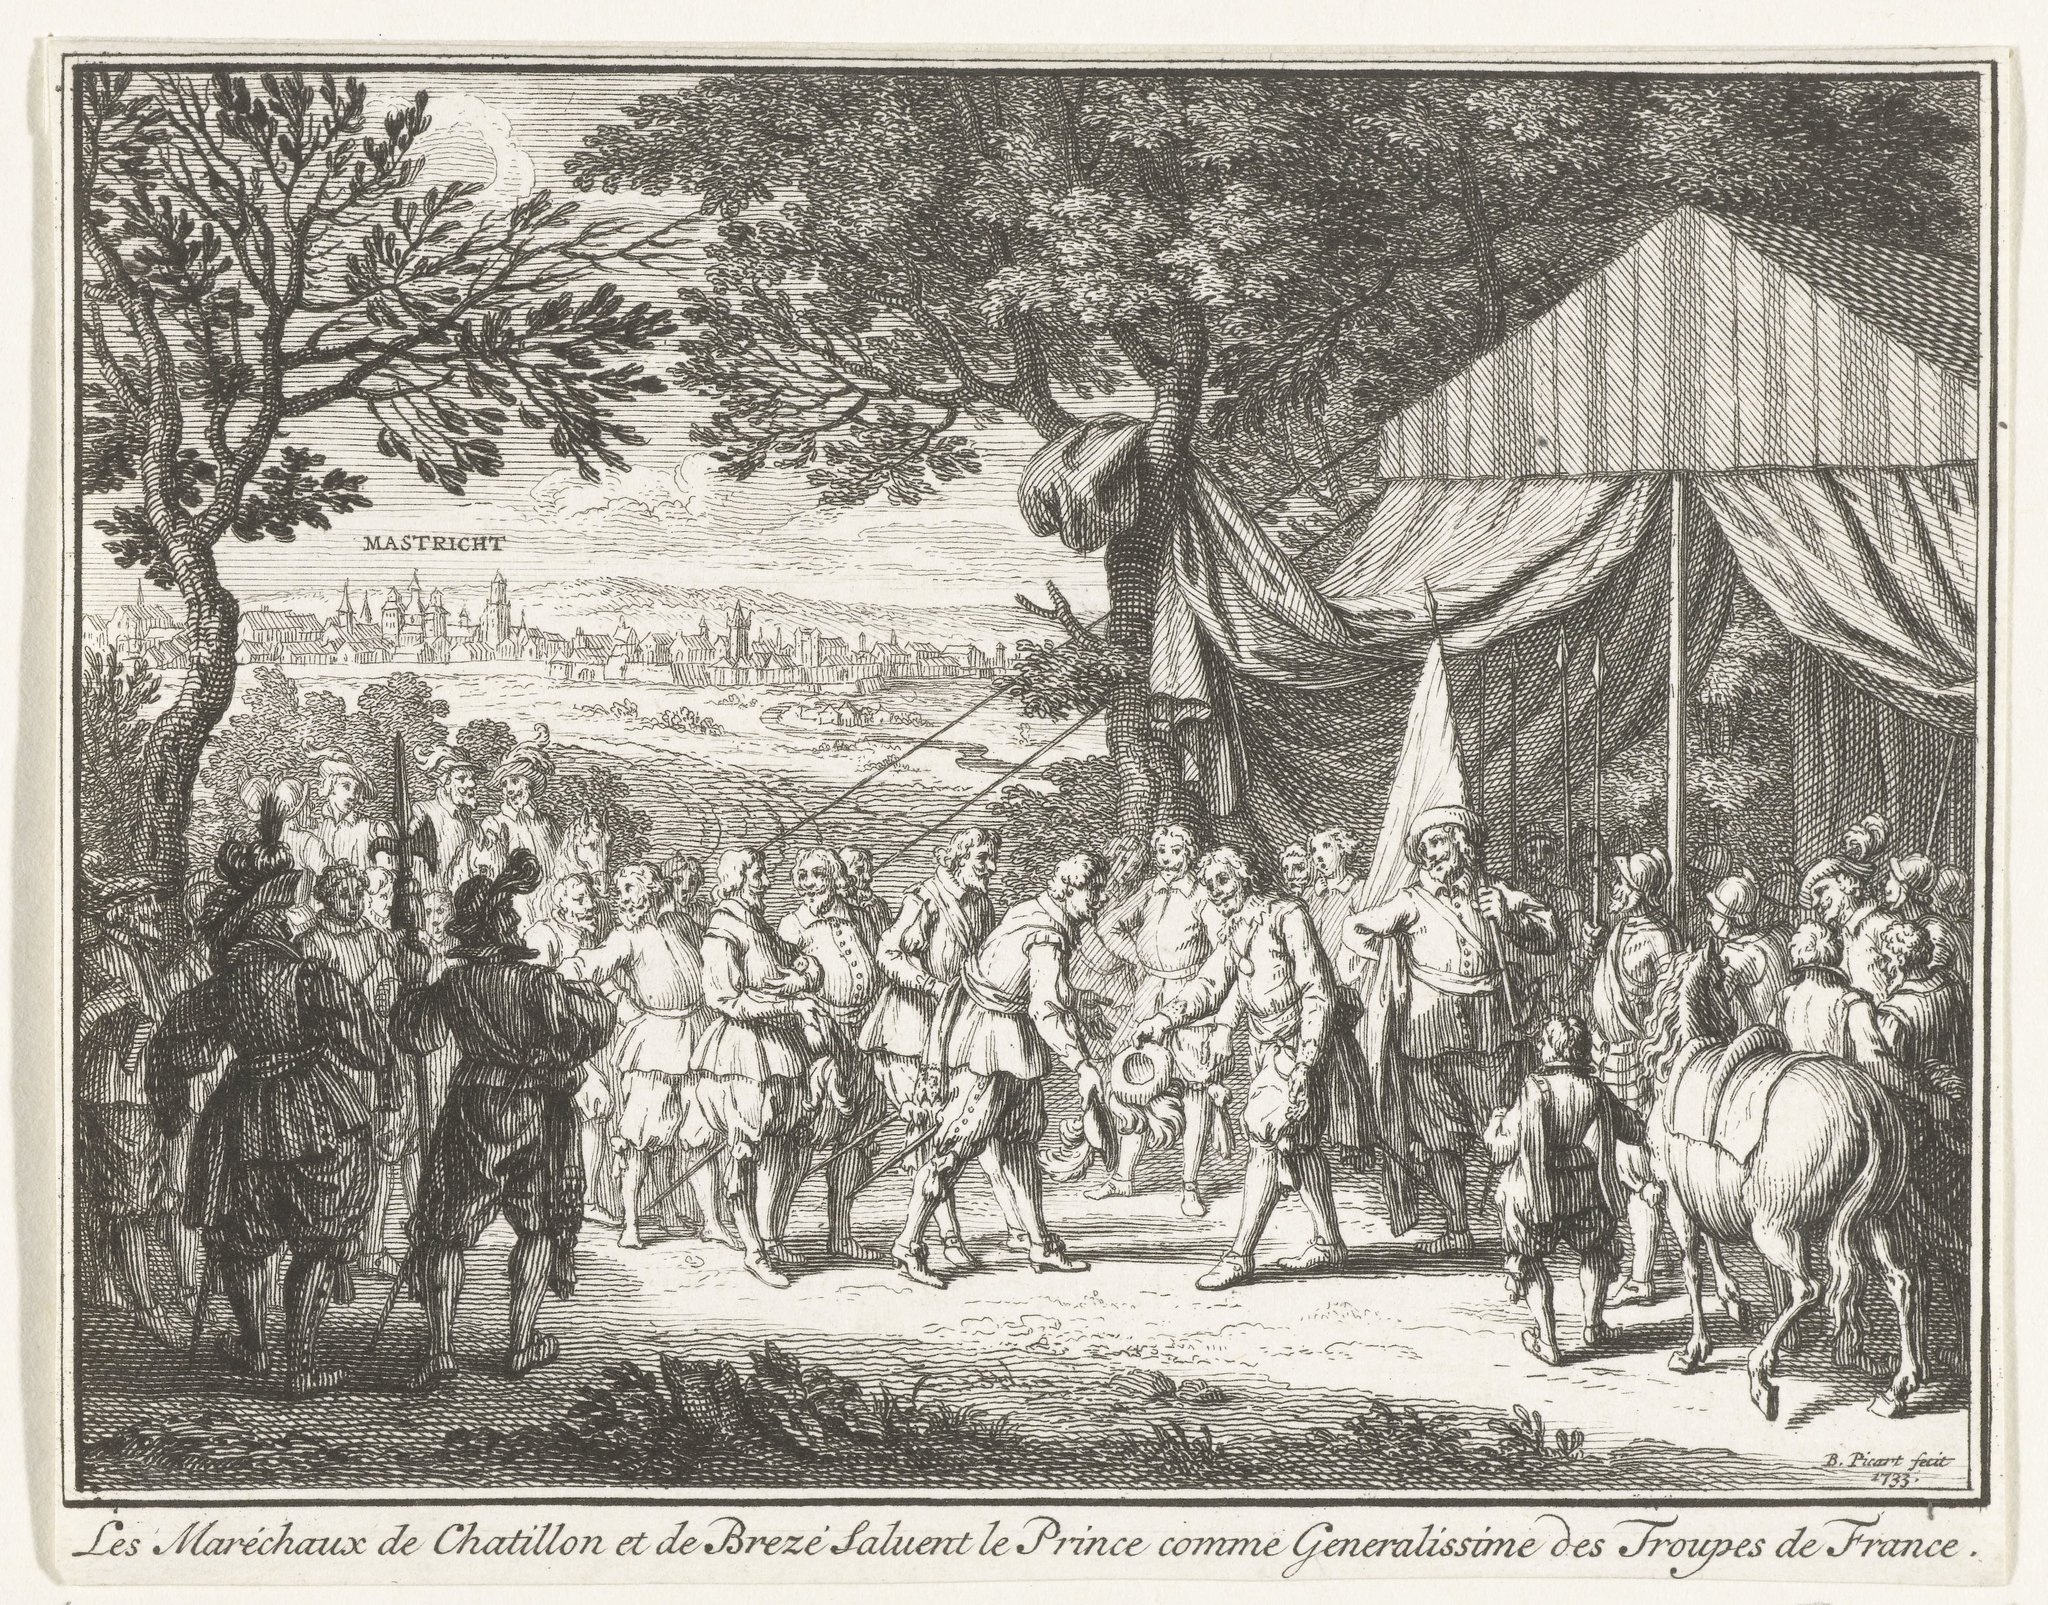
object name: history print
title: Veldmaarschalken de Chatellon en de Breze begroeten prins Frederik Hendrik, 1632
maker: bernard picart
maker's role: draughtsman, print maker, publisher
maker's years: 1673-1733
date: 1733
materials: paper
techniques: etching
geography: northern netherlands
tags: delft, the hague, frederick henry (prince of orange), siege, position war, maastricht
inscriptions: date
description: Gebruikt als illustratie in: Frederik Hendrik prins van Oranje, Isaac de Beausobre, Bernard Picart, Mémoires de Frederic Henri, prince d'Orange, Pierre Humbert, Amsterdam 1733. Niet in Frederik Muller; door het RPK toegevoegd nummer.